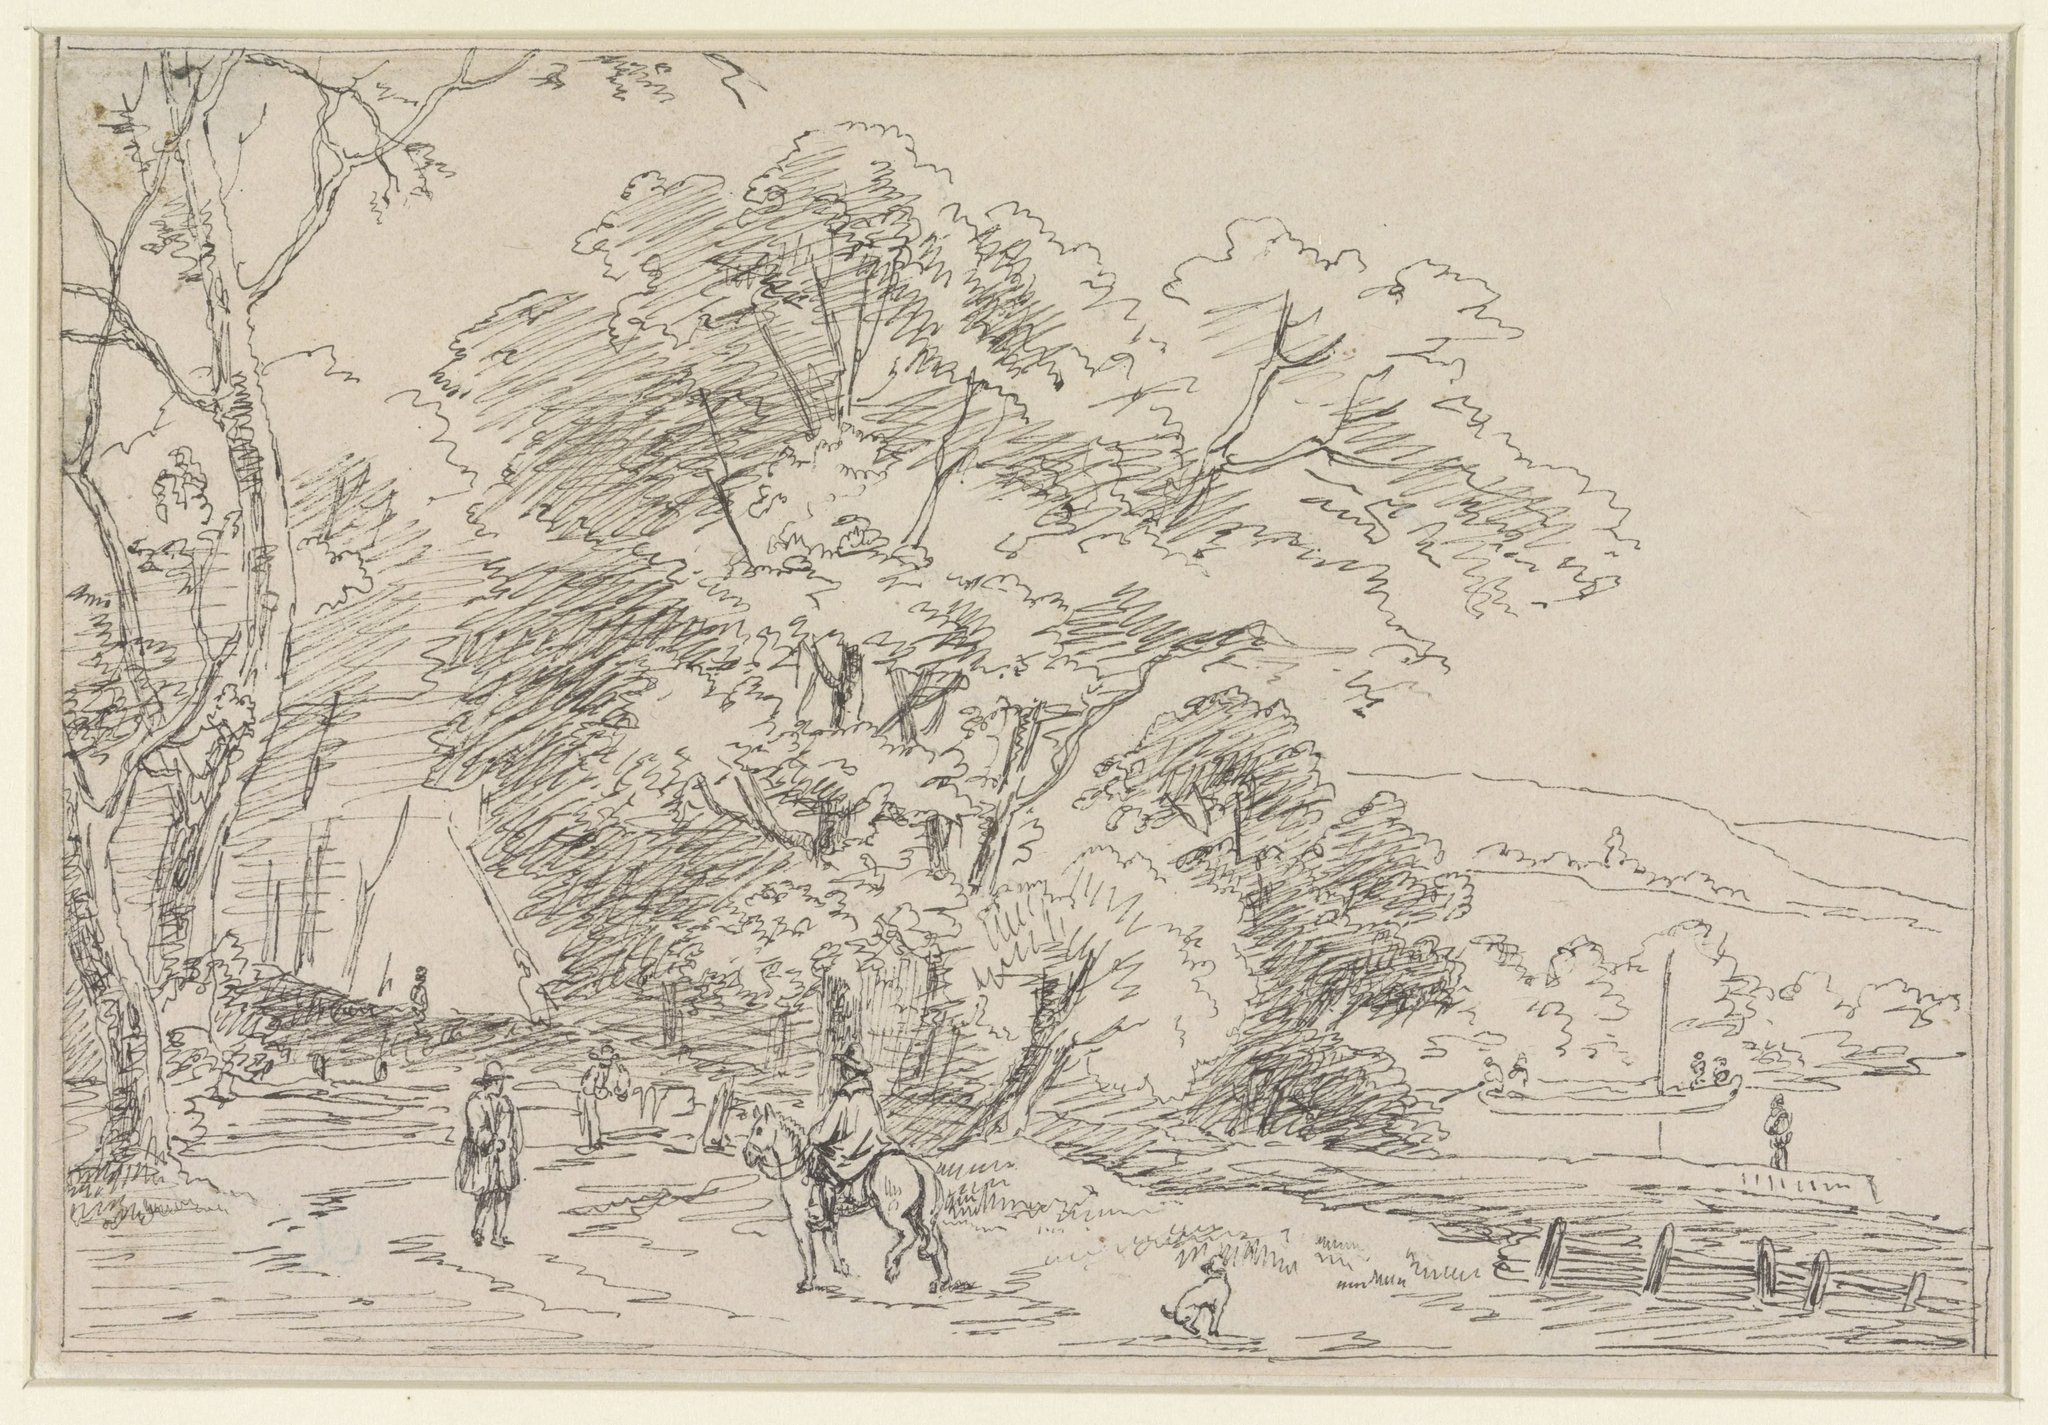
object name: drawing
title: Landschap met een ruiter, wandelaars en een hond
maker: jean théodore joseph linnig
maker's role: draughtsman, print maker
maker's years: 1815-1891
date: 1847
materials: chalk, ink, paper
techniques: pen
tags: landscapes in the temperate zone